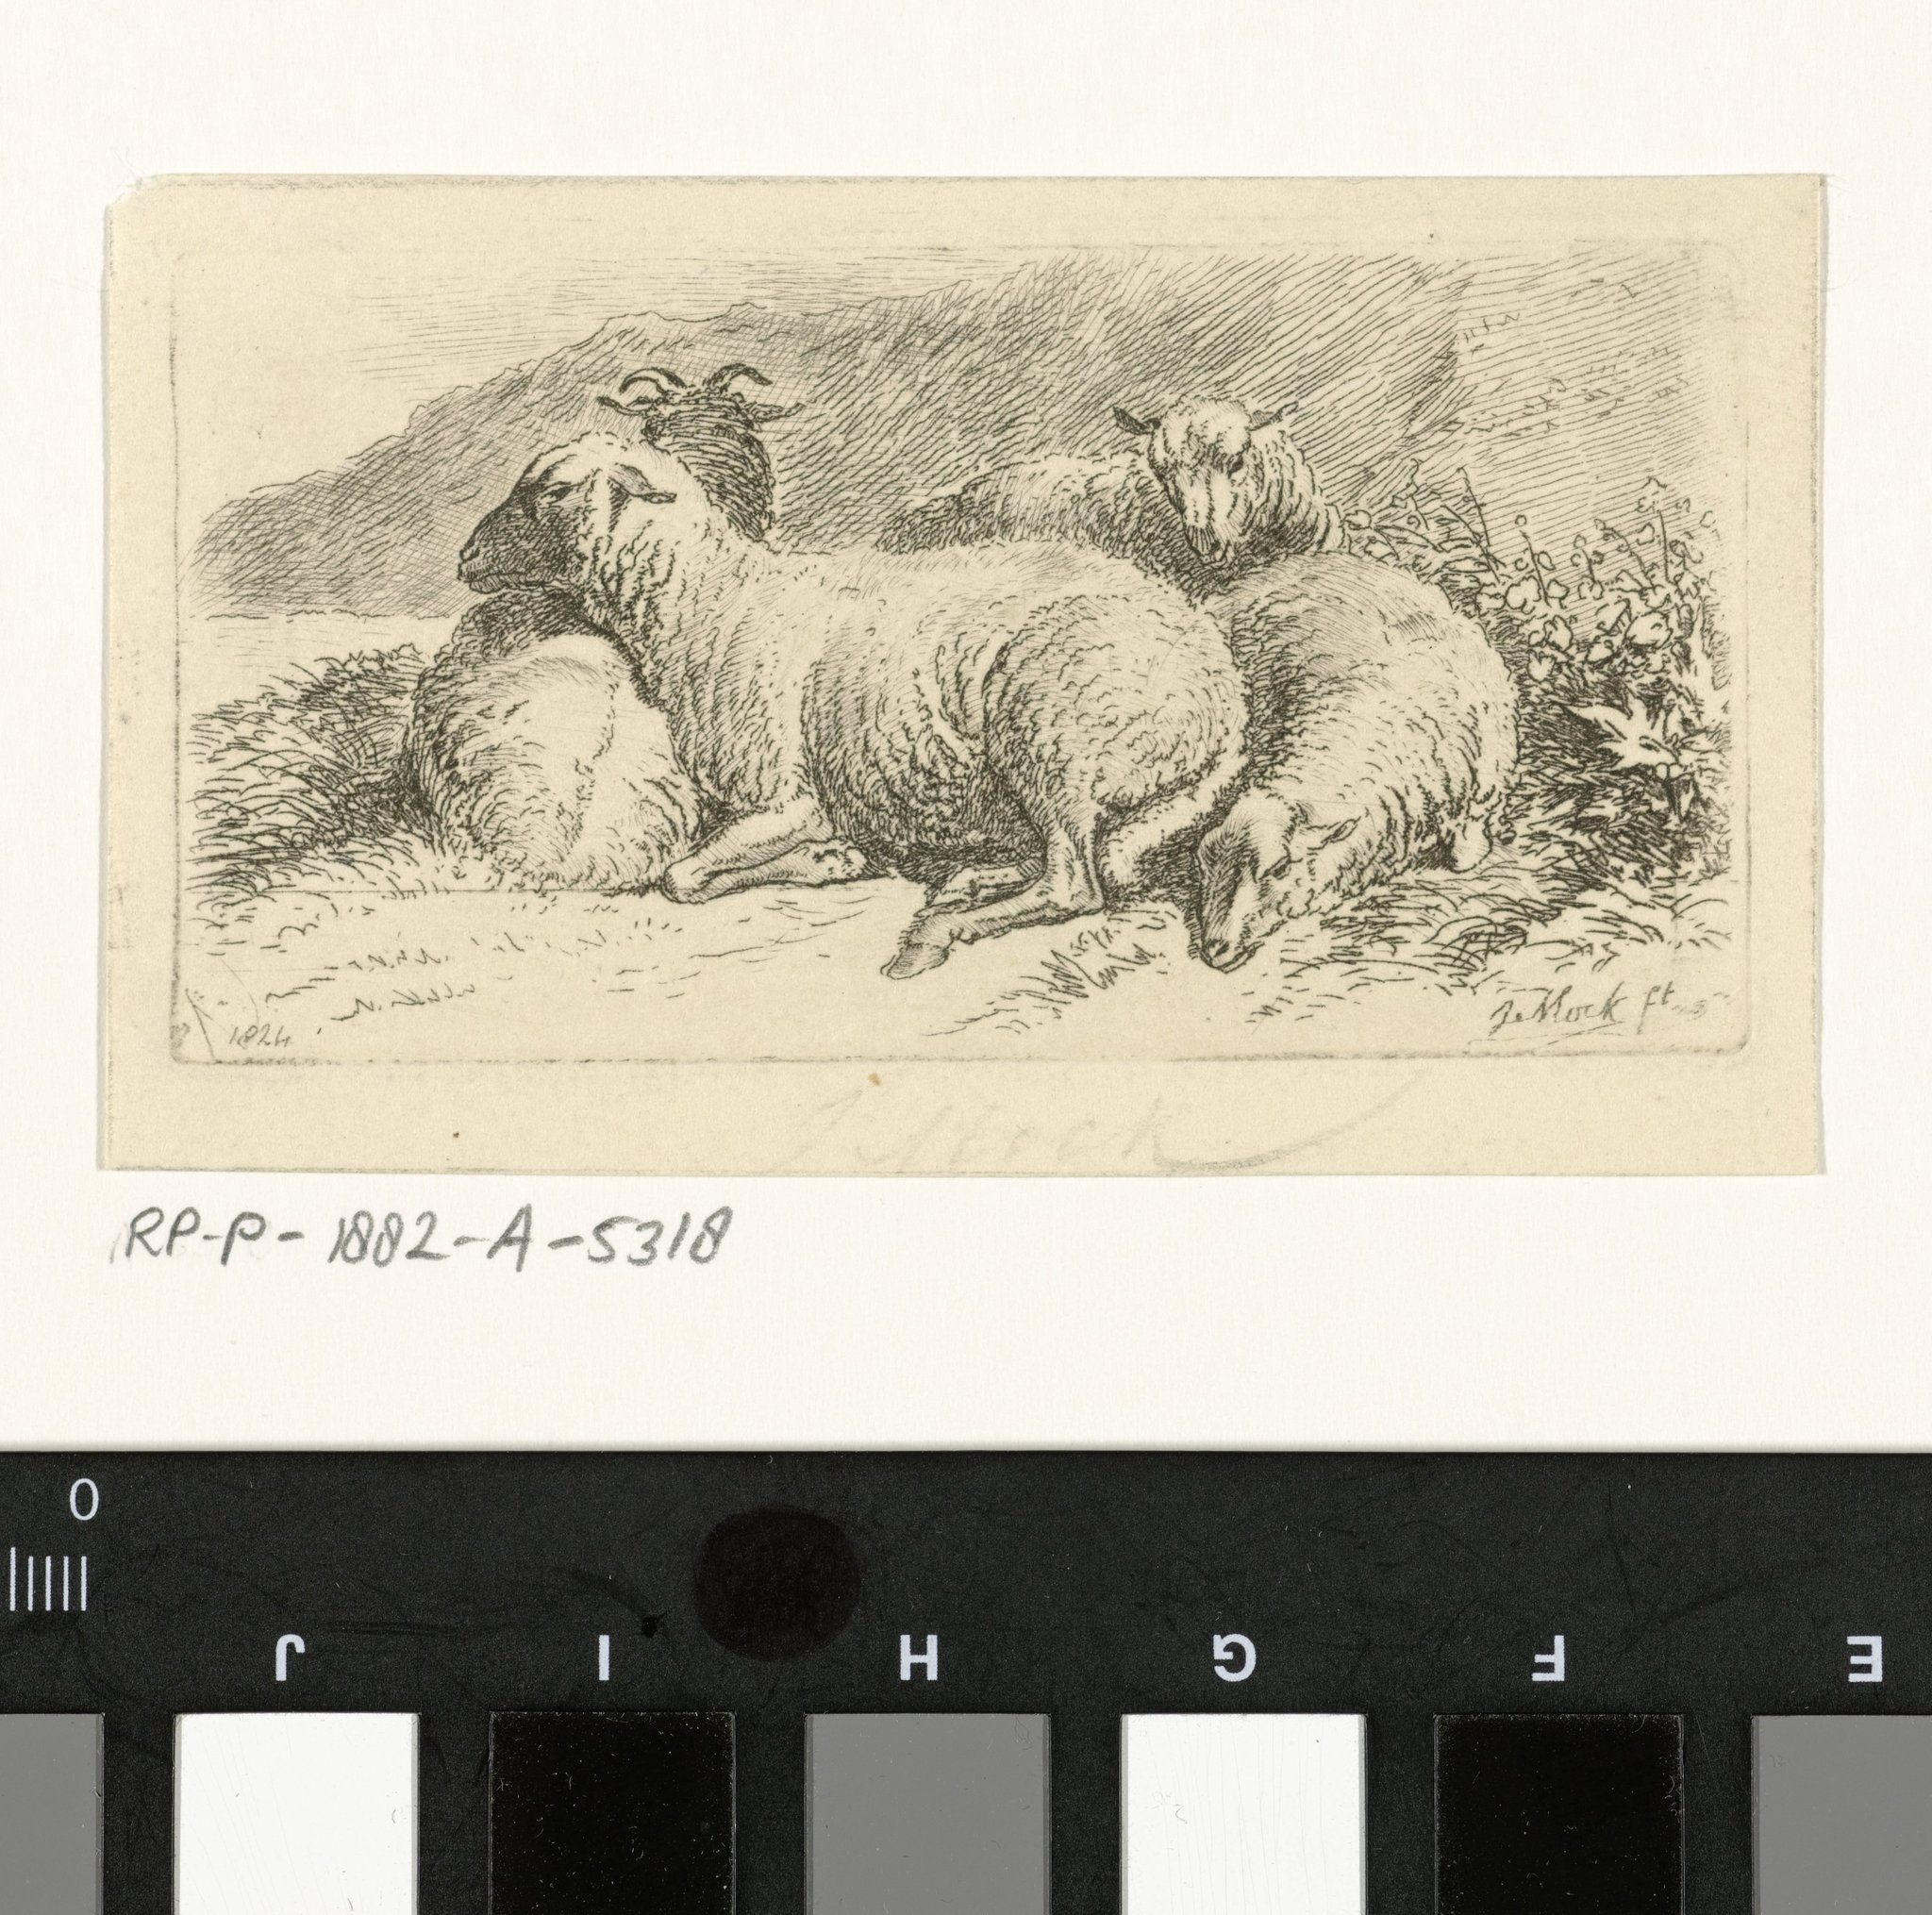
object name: print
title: Vier liggende schapen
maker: johannes mock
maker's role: draughtsman, painter, print maker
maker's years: 1800-1884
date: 1824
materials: paper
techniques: etching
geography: netherlands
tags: sheep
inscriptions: collector's mark: Lugt 2228